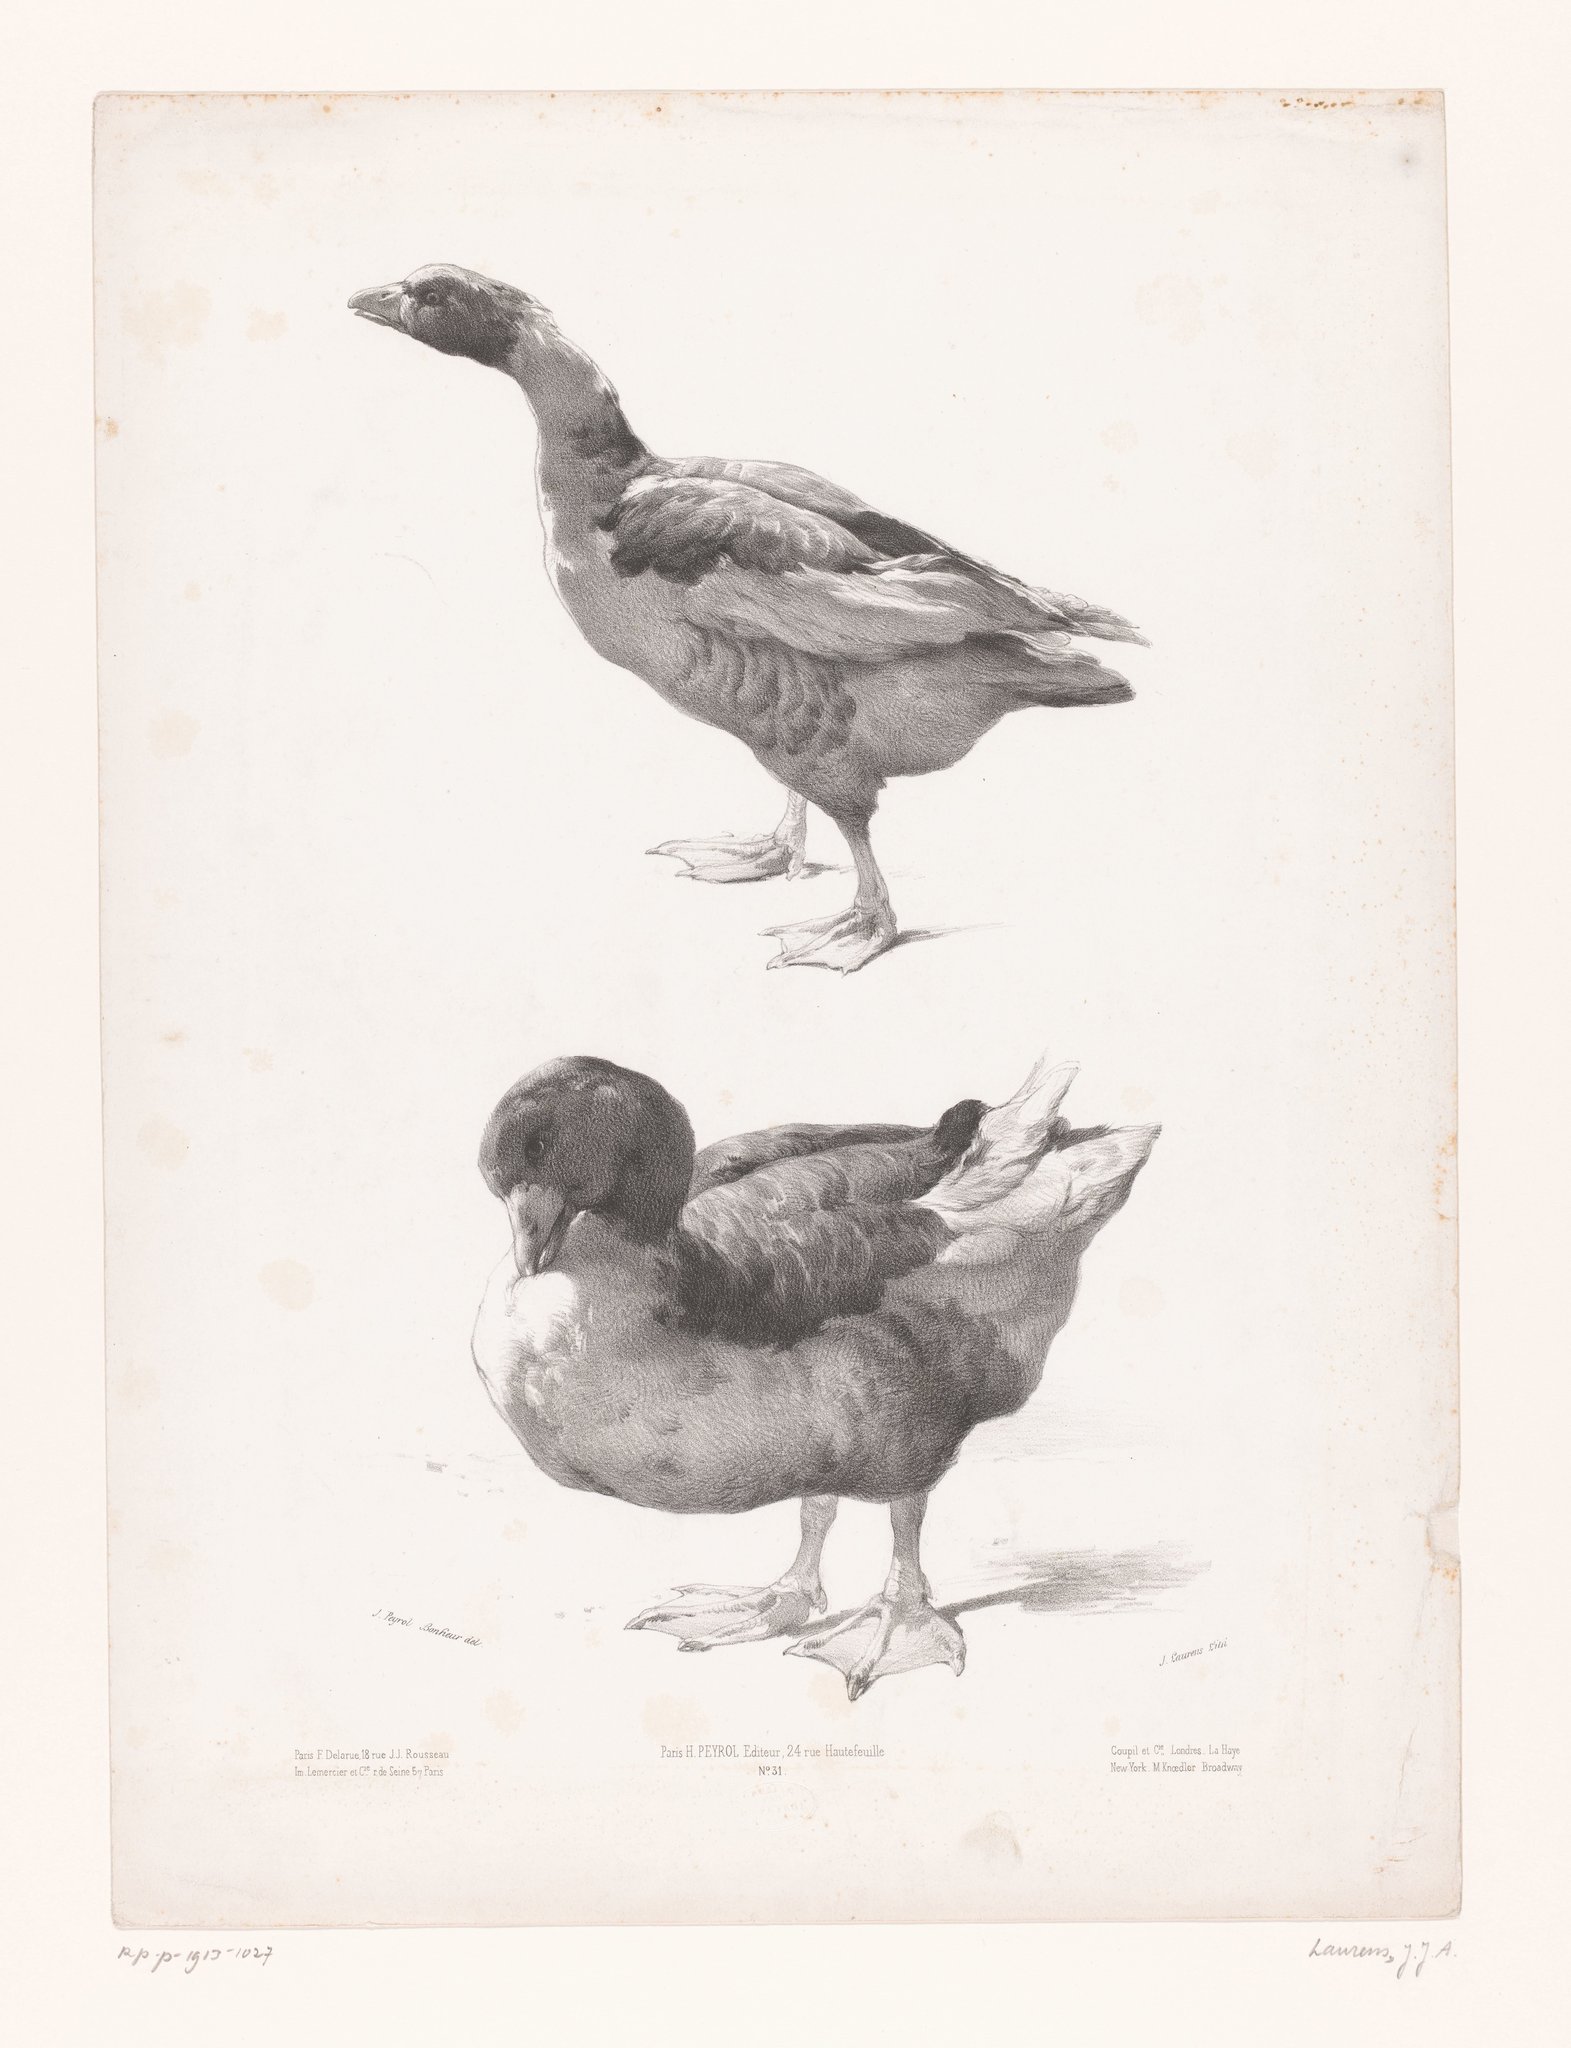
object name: print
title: Studie van een gans en een eend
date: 1865-1878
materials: paper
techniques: lithograph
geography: new york city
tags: water-birds: goose, water-birds: duck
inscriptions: check stamp: Lugt 4777, collector's mark: Lugt 2228a